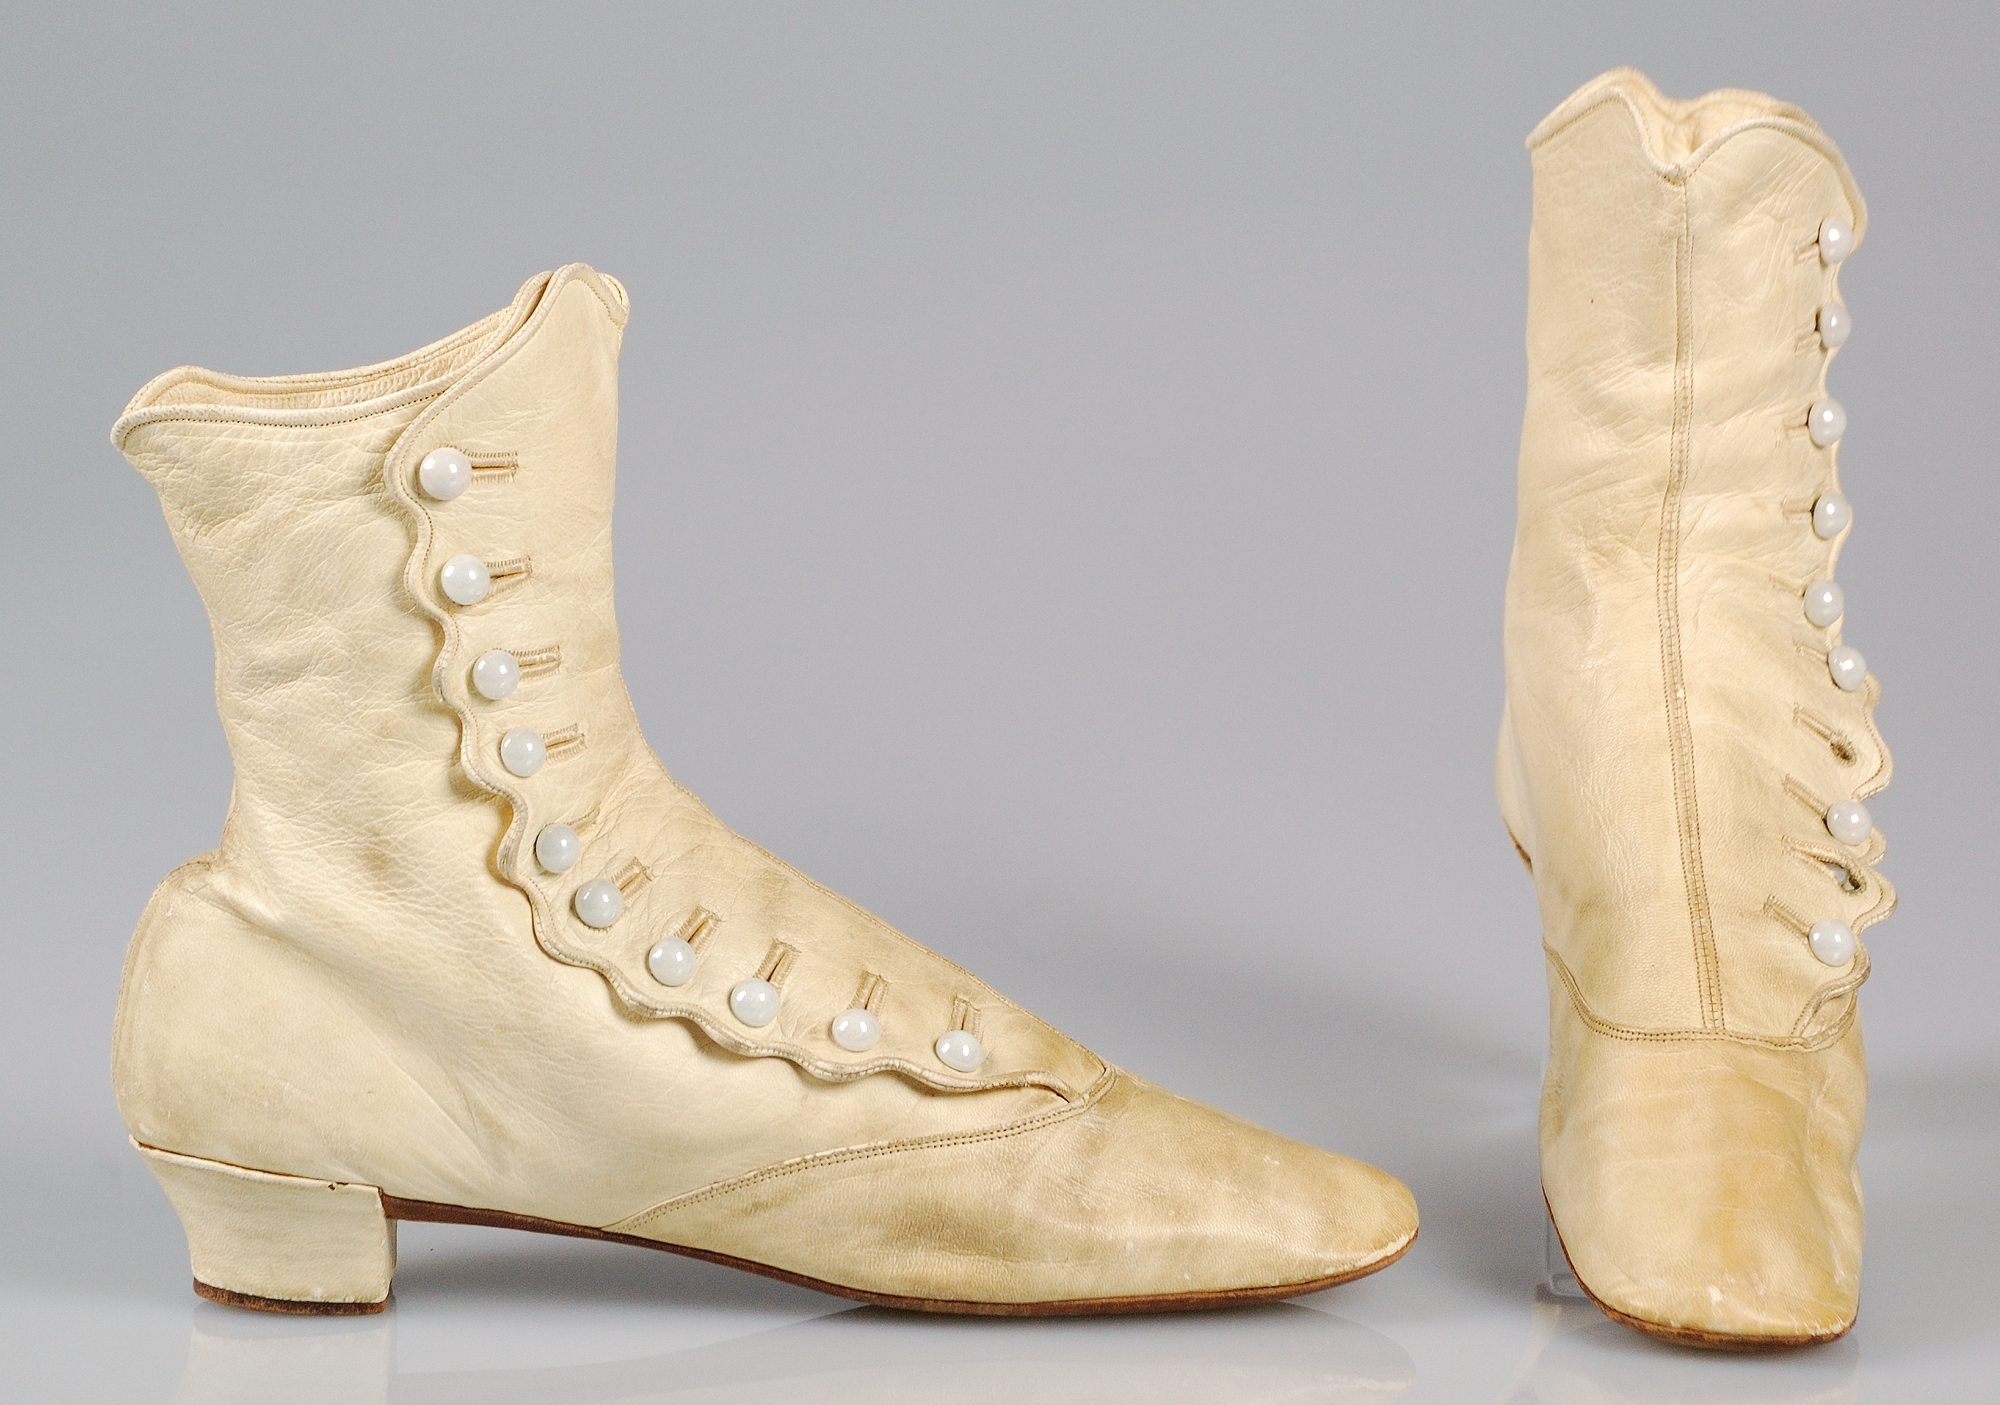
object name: wedding boot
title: Wedding boots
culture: american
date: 1865-1879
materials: leather